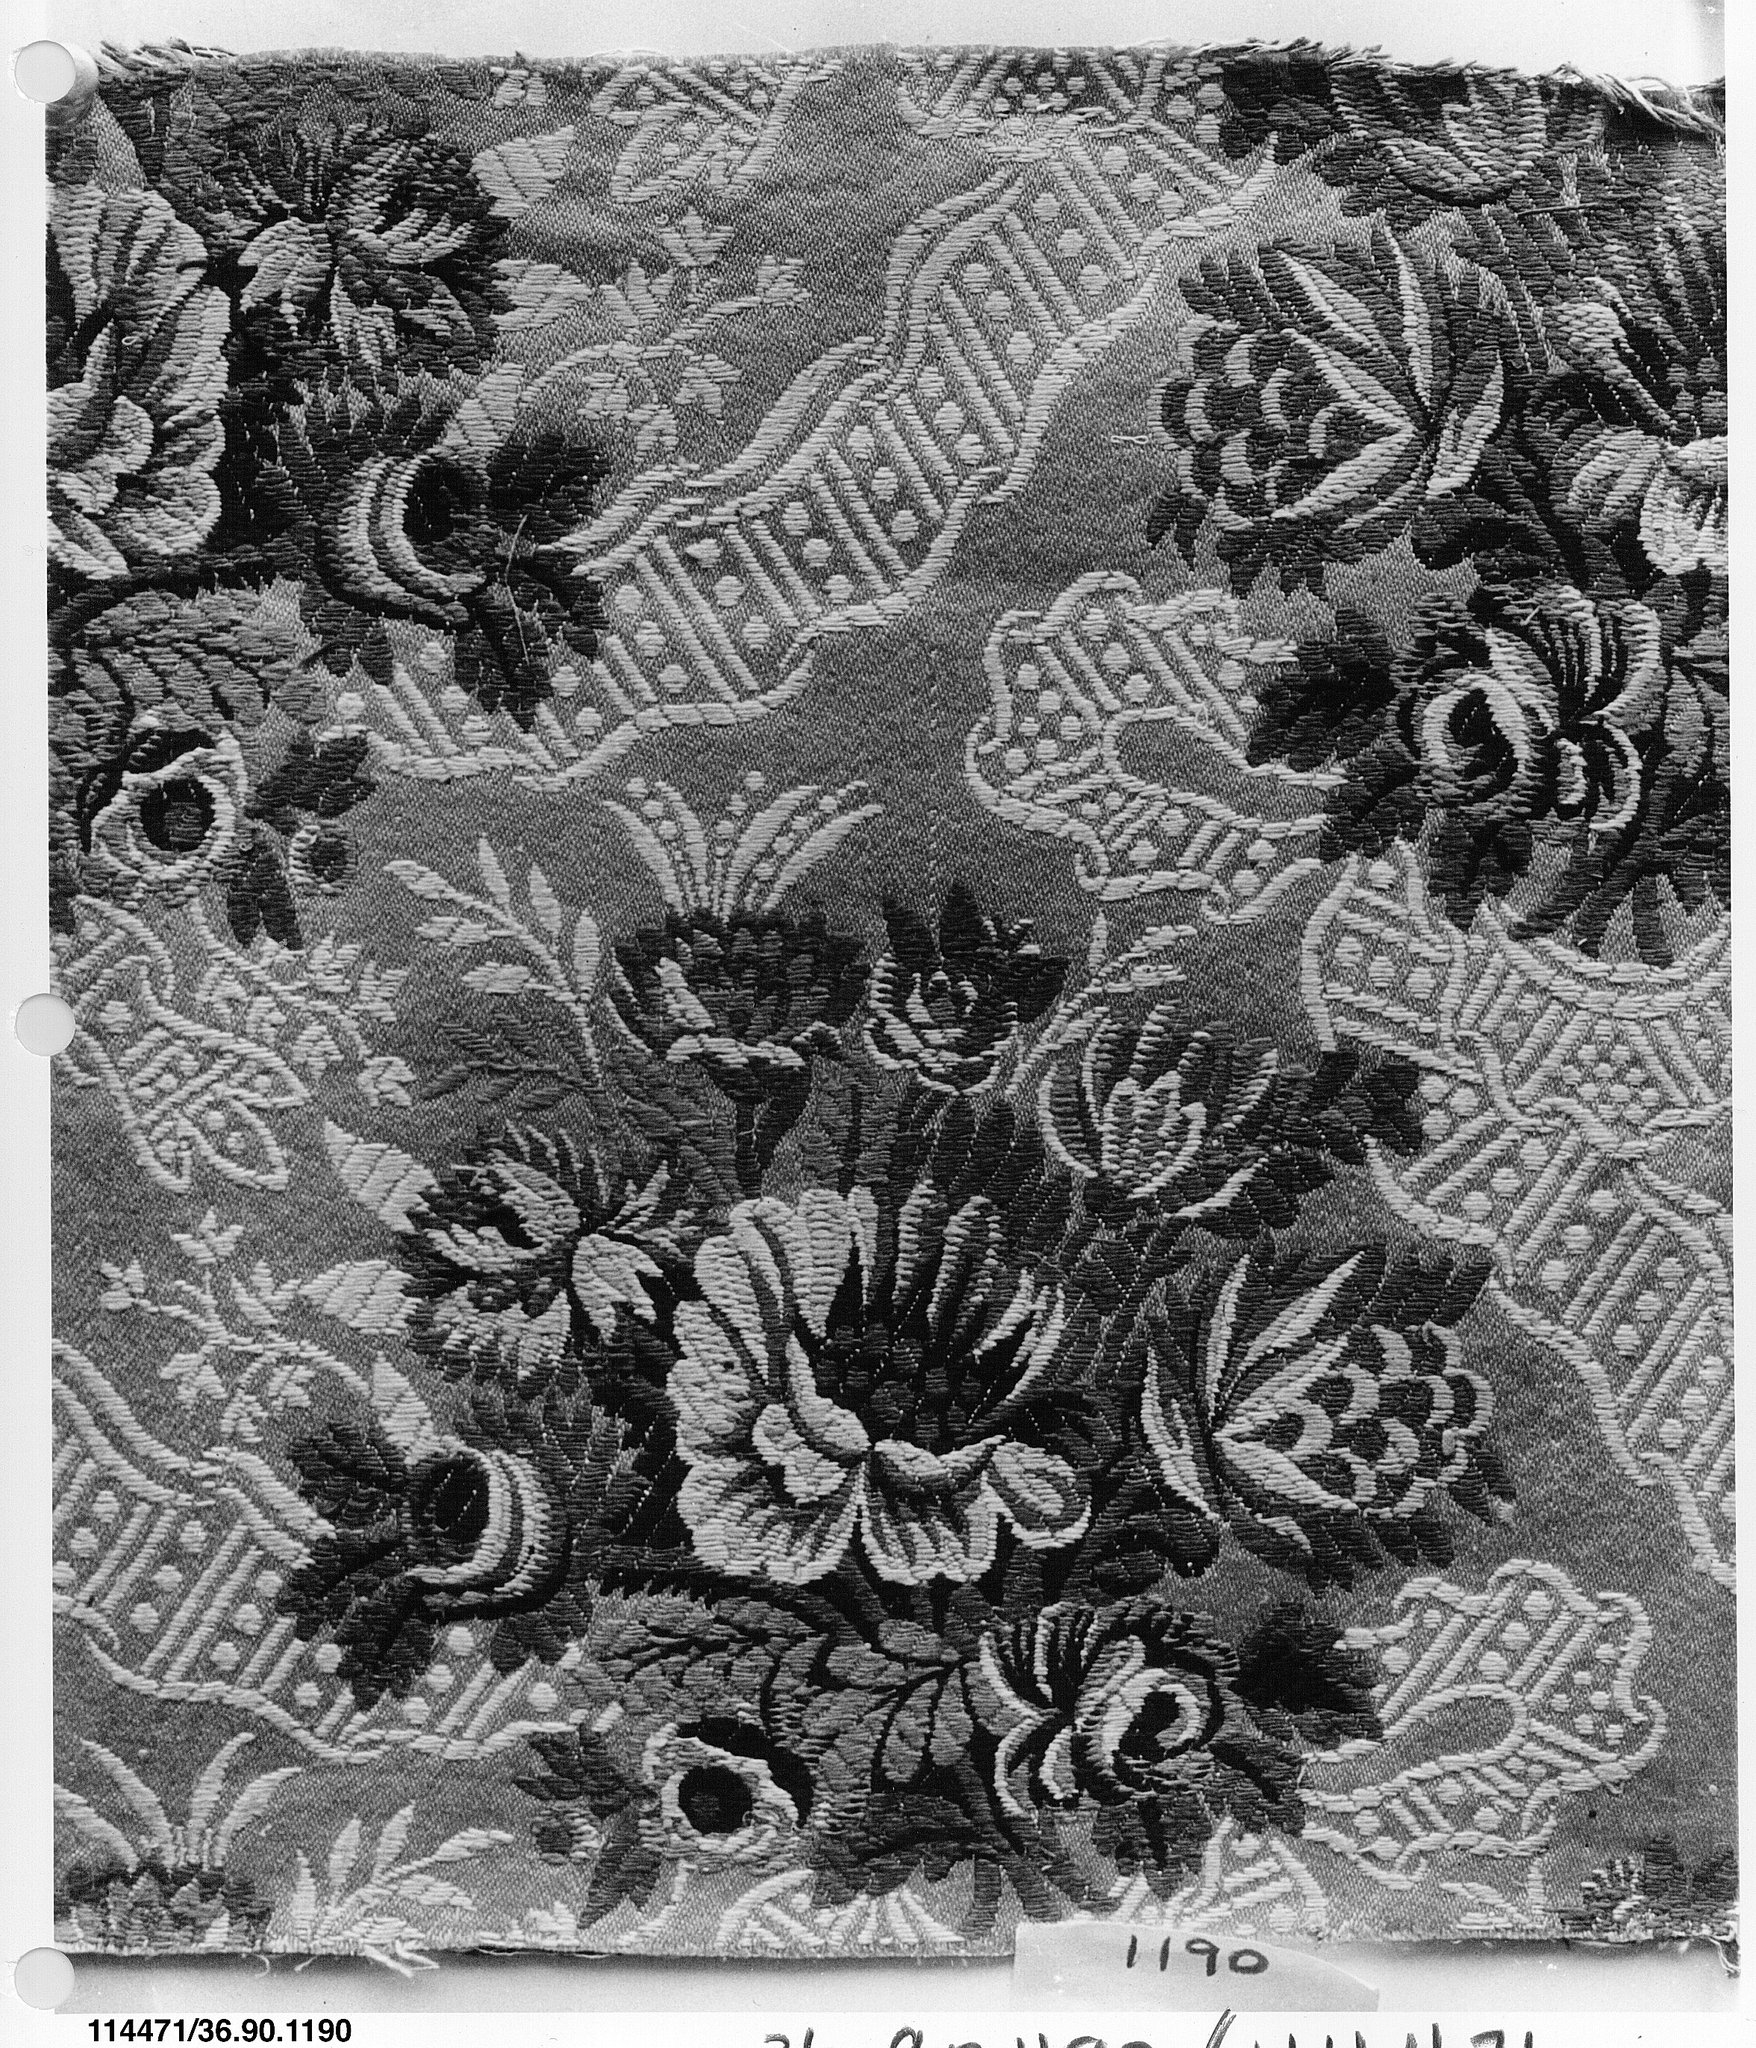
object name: piece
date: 1801-1900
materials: silk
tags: flowers,leaves